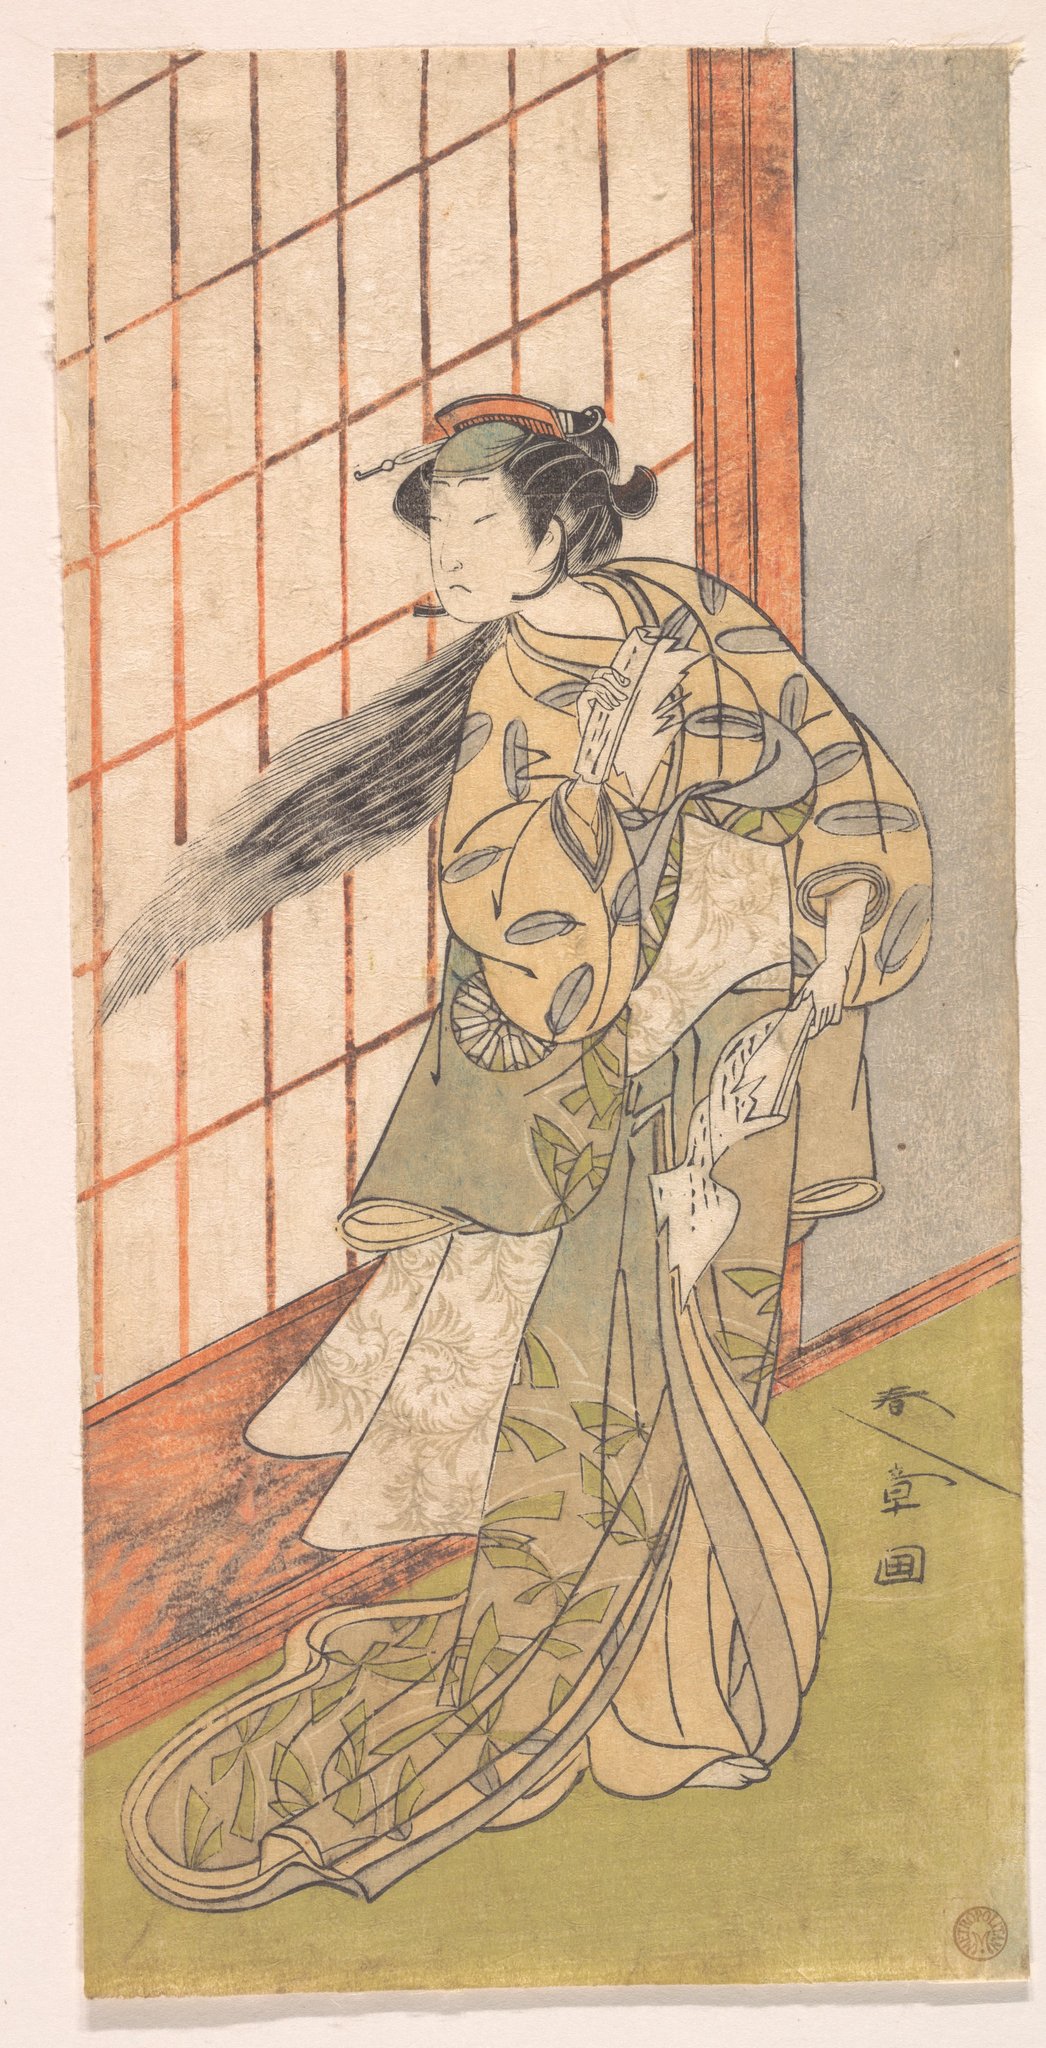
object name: woodblock print nishiki e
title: The First Nakamura Tomijuro as an Angry Woman Standing in a Room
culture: japanese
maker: katsukawa shunshō 勝川春章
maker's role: artist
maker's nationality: japanese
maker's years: 1726-1792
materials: ink, paper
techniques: nishiki e, woodblock print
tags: women,actors